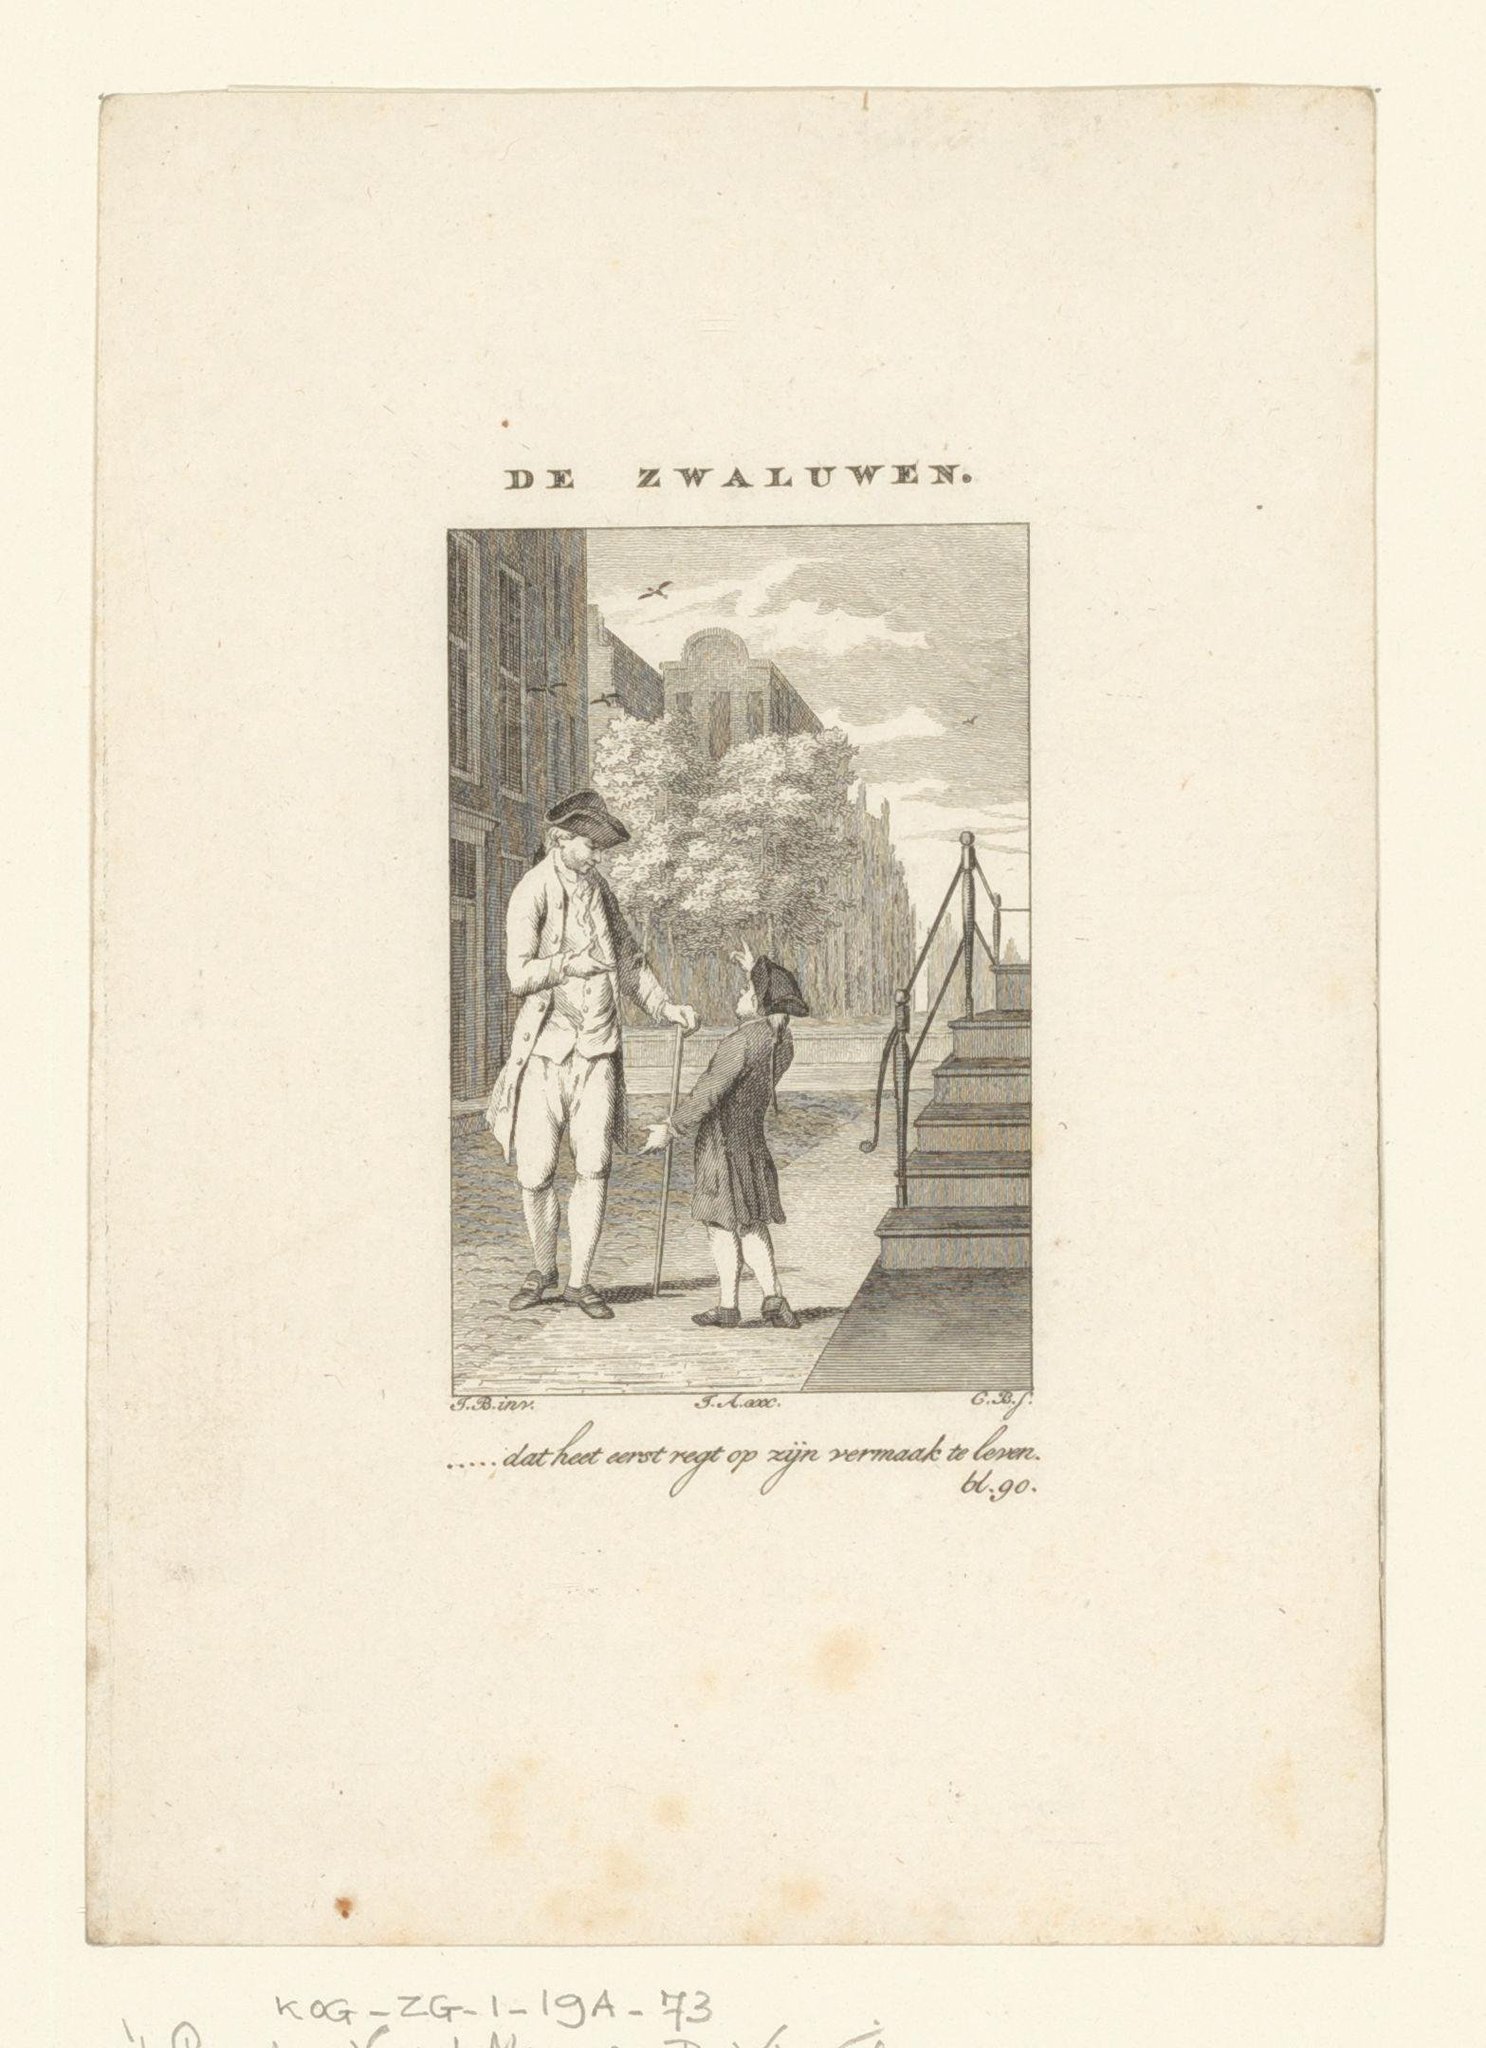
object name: print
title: Jongen wijst naar zwaluwen in de lucht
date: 1846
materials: paper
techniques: engraving, etching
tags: child, song-birds: swallow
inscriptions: stamp, stamp, collector's mark: Lugt 1641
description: Onderaan de tekst: ...dat heet eerst regt op zijn vermaakt te leven, bl. 90. Onderwerpsrubrieken binnen de Atlas Zeden en Gewoonten: Zeden en Gewoonten in Engeren Zin, Des menschen beging, midden en einde, Kinderleven – Kinderspel en Kinderprenten.